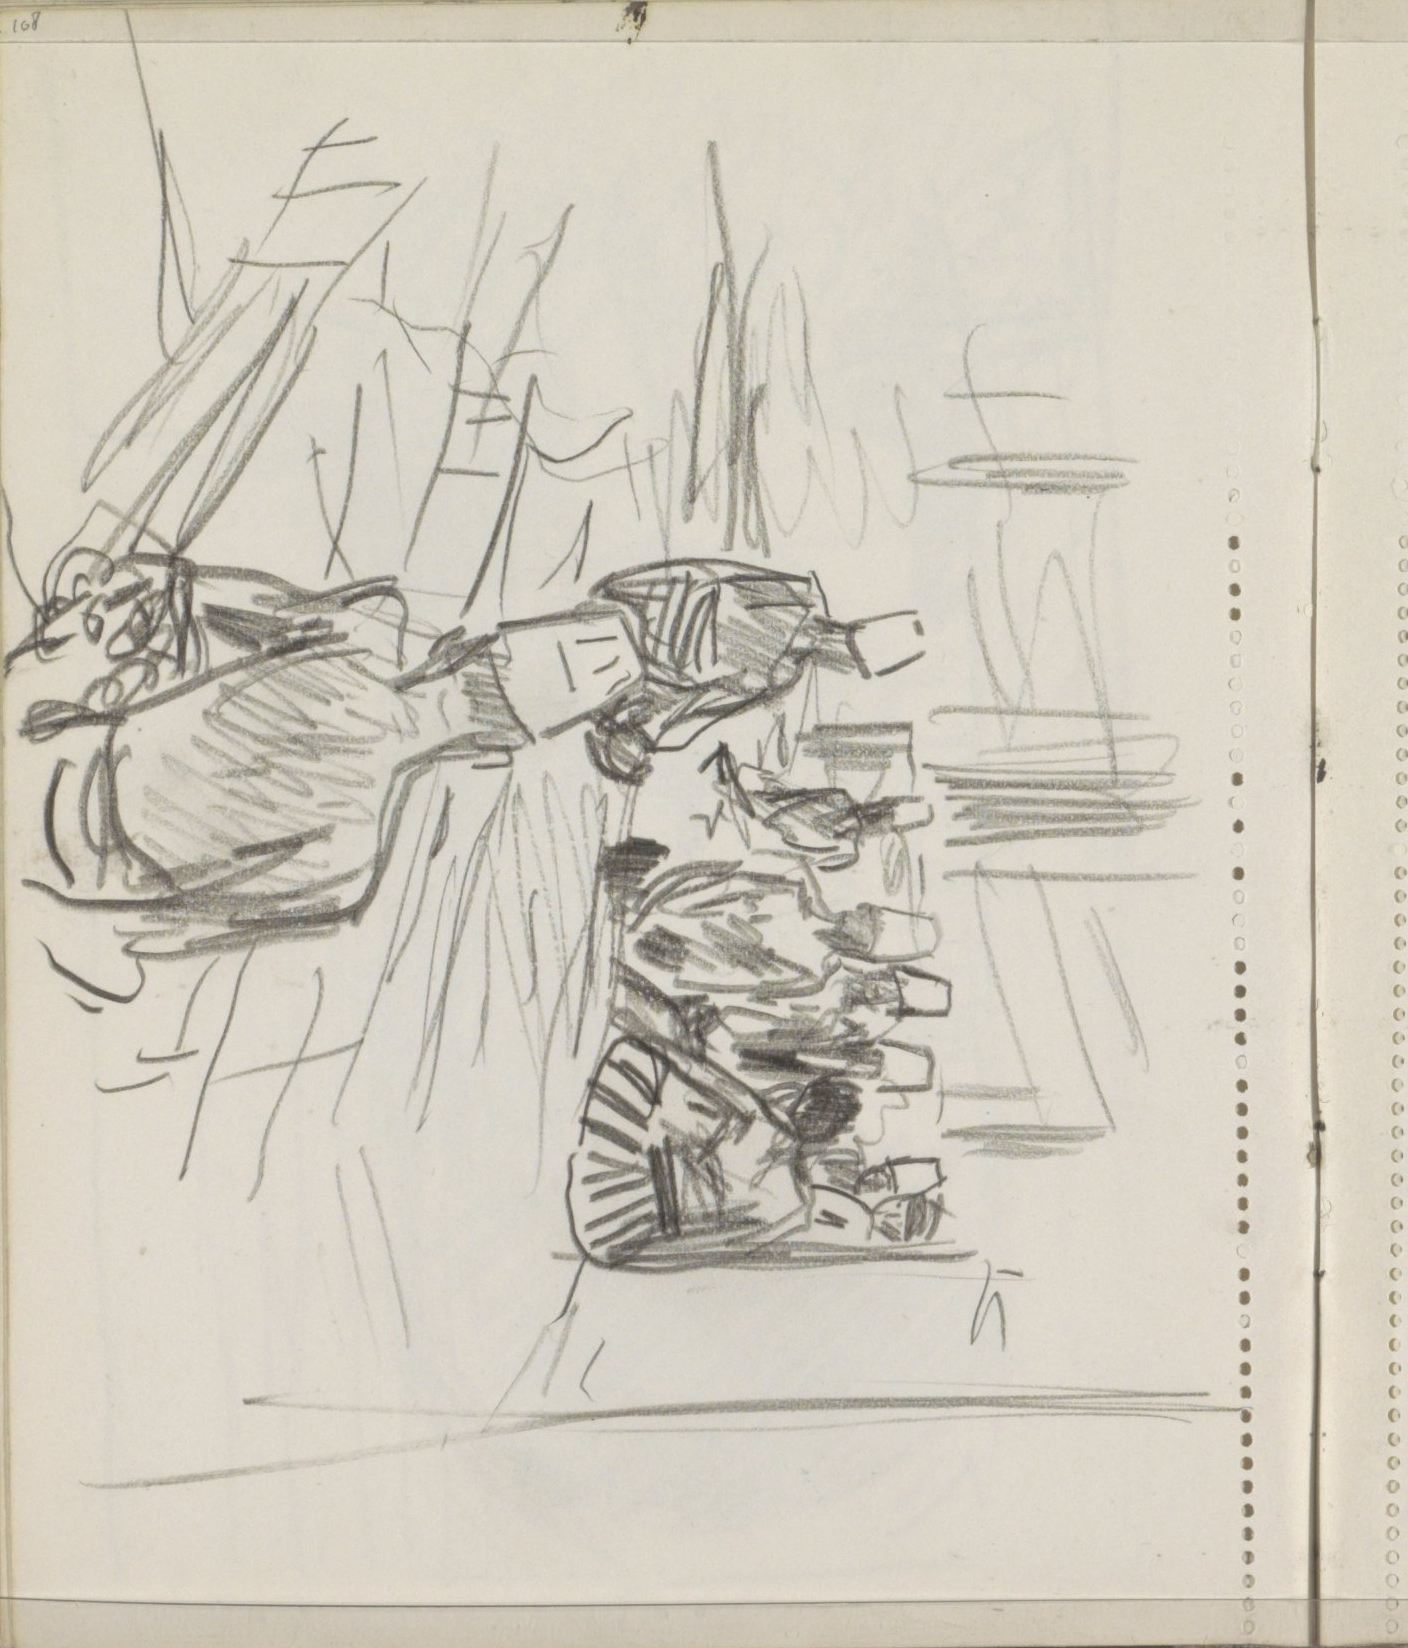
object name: sketchbook leaf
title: Mannen met fezzen zittend op een trap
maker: marius bauer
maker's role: draughtsman, print maker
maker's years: 1867-1932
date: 1925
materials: chalk, paper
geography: indonesia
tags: sitting figure, flight of steps, head-gear, street (+ city(-scape) with figures, staffage)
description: Pagina 108 uit een schetsboek met 67 bladen.